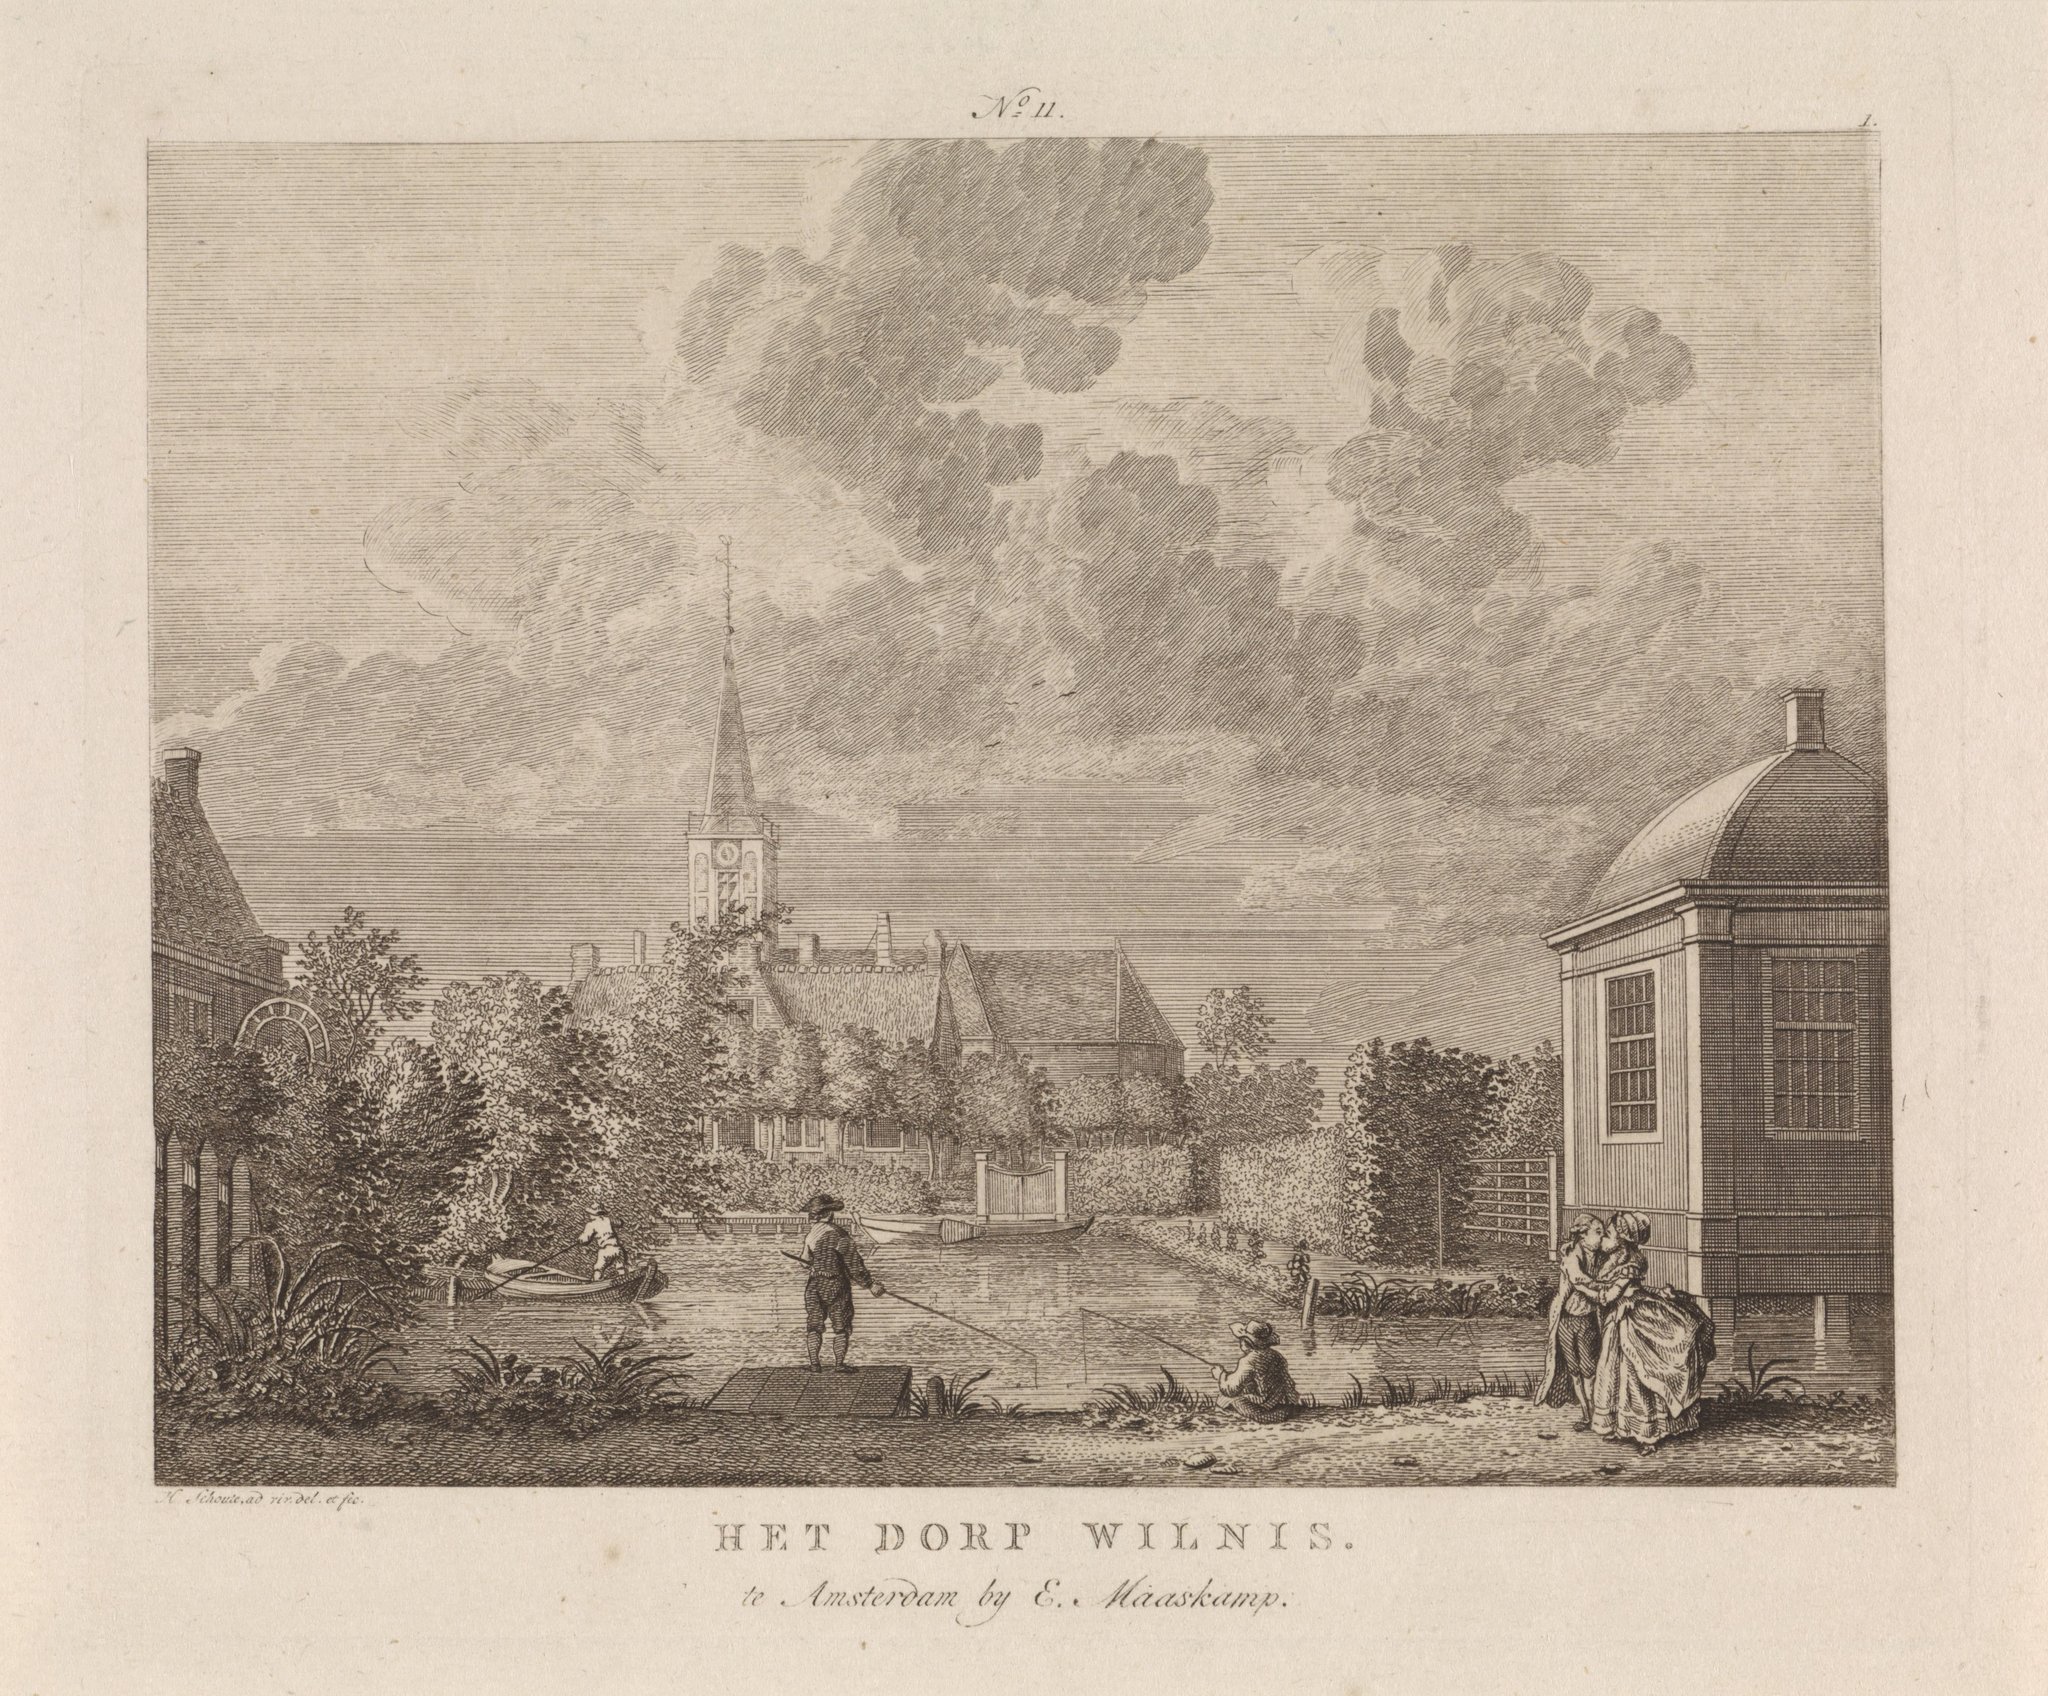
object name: print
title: Het dorp Wilnis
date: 1762-1822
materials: paper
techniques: etching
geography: amsterdam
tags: village, couple of lovers, fisherman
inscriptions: collector's mark: Lugt 2228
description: Een vrijend paartje staat voor een theepaviljoen bij een vijver. Aan de oever zitten vissers. Op de achtergrond een kerk.